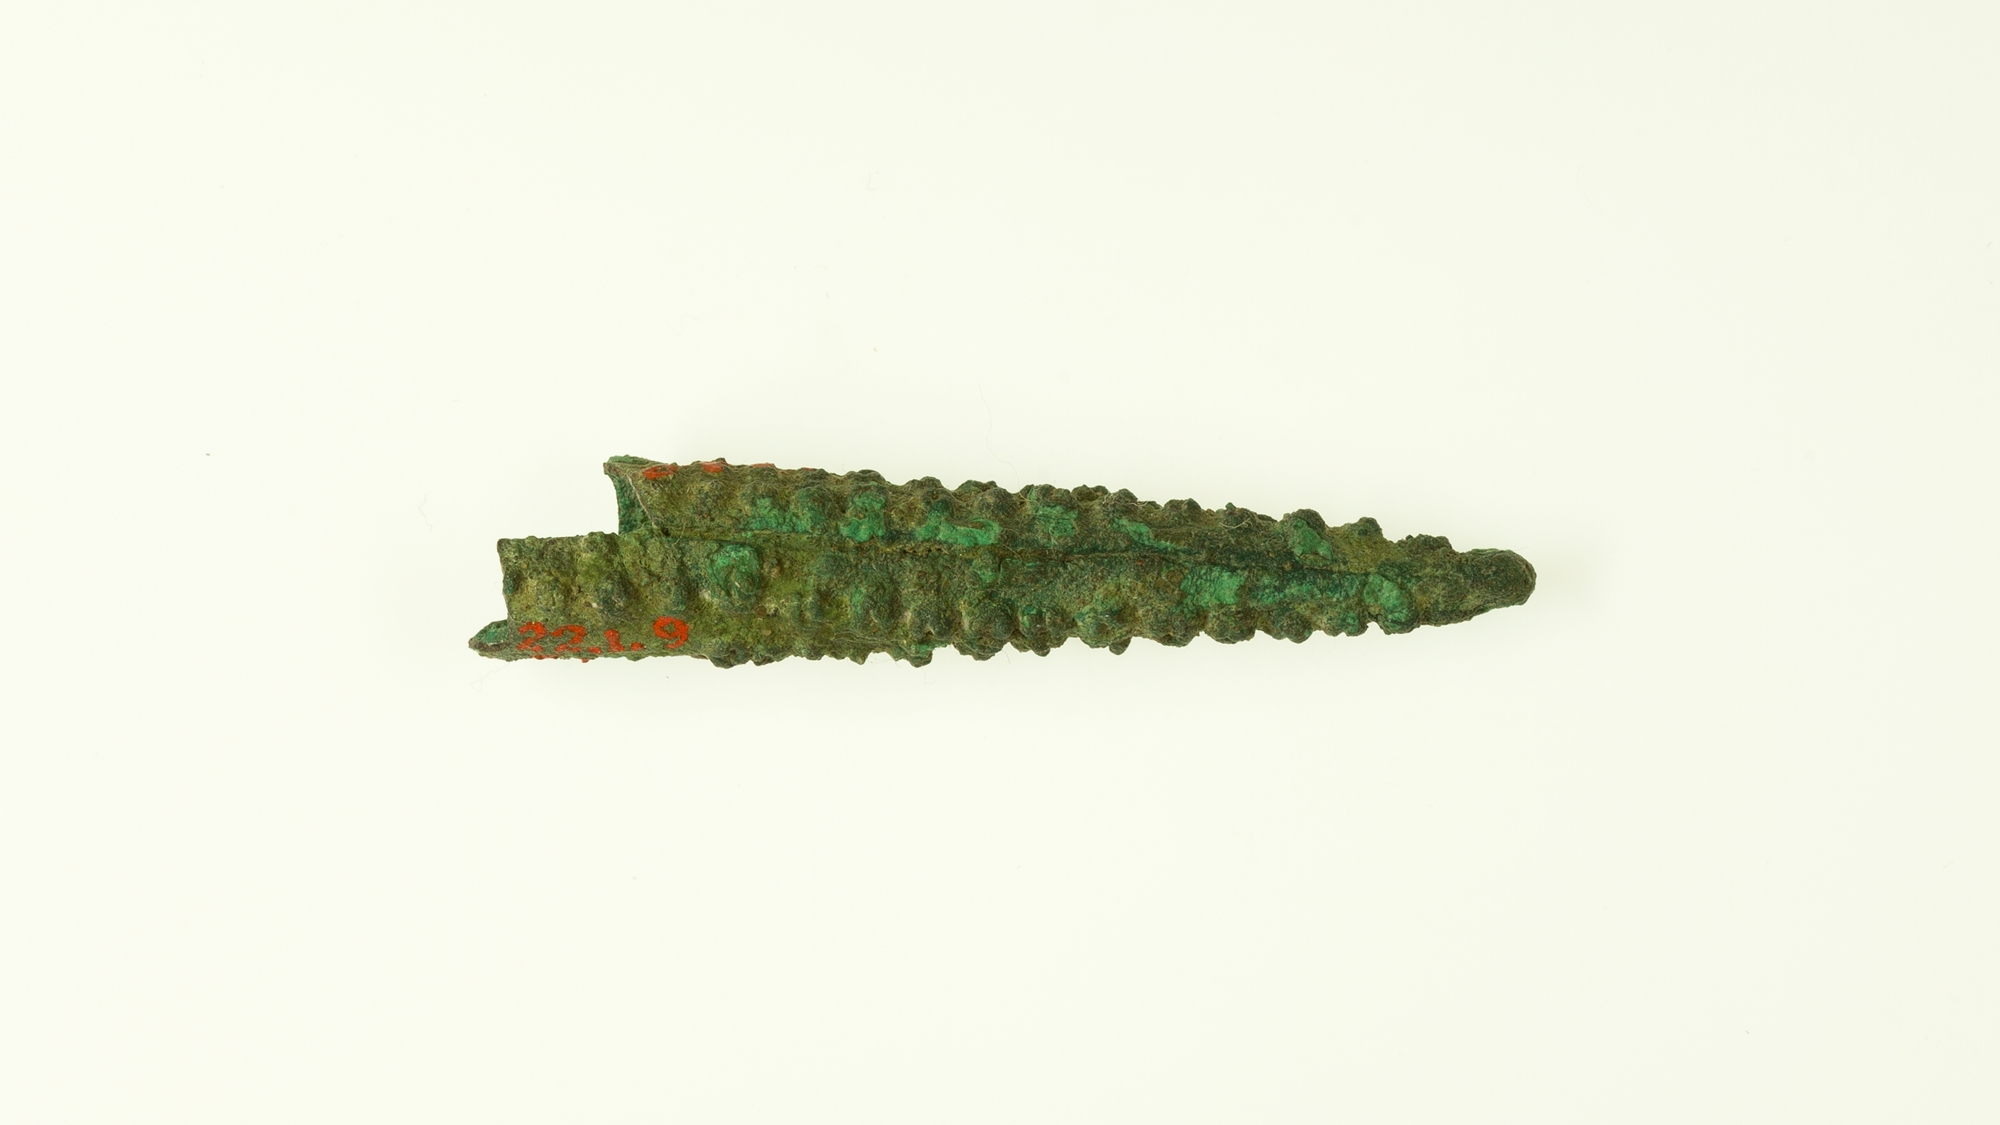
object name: siphon nozzle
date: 1295-1070 BCE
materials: bronze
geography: egypt